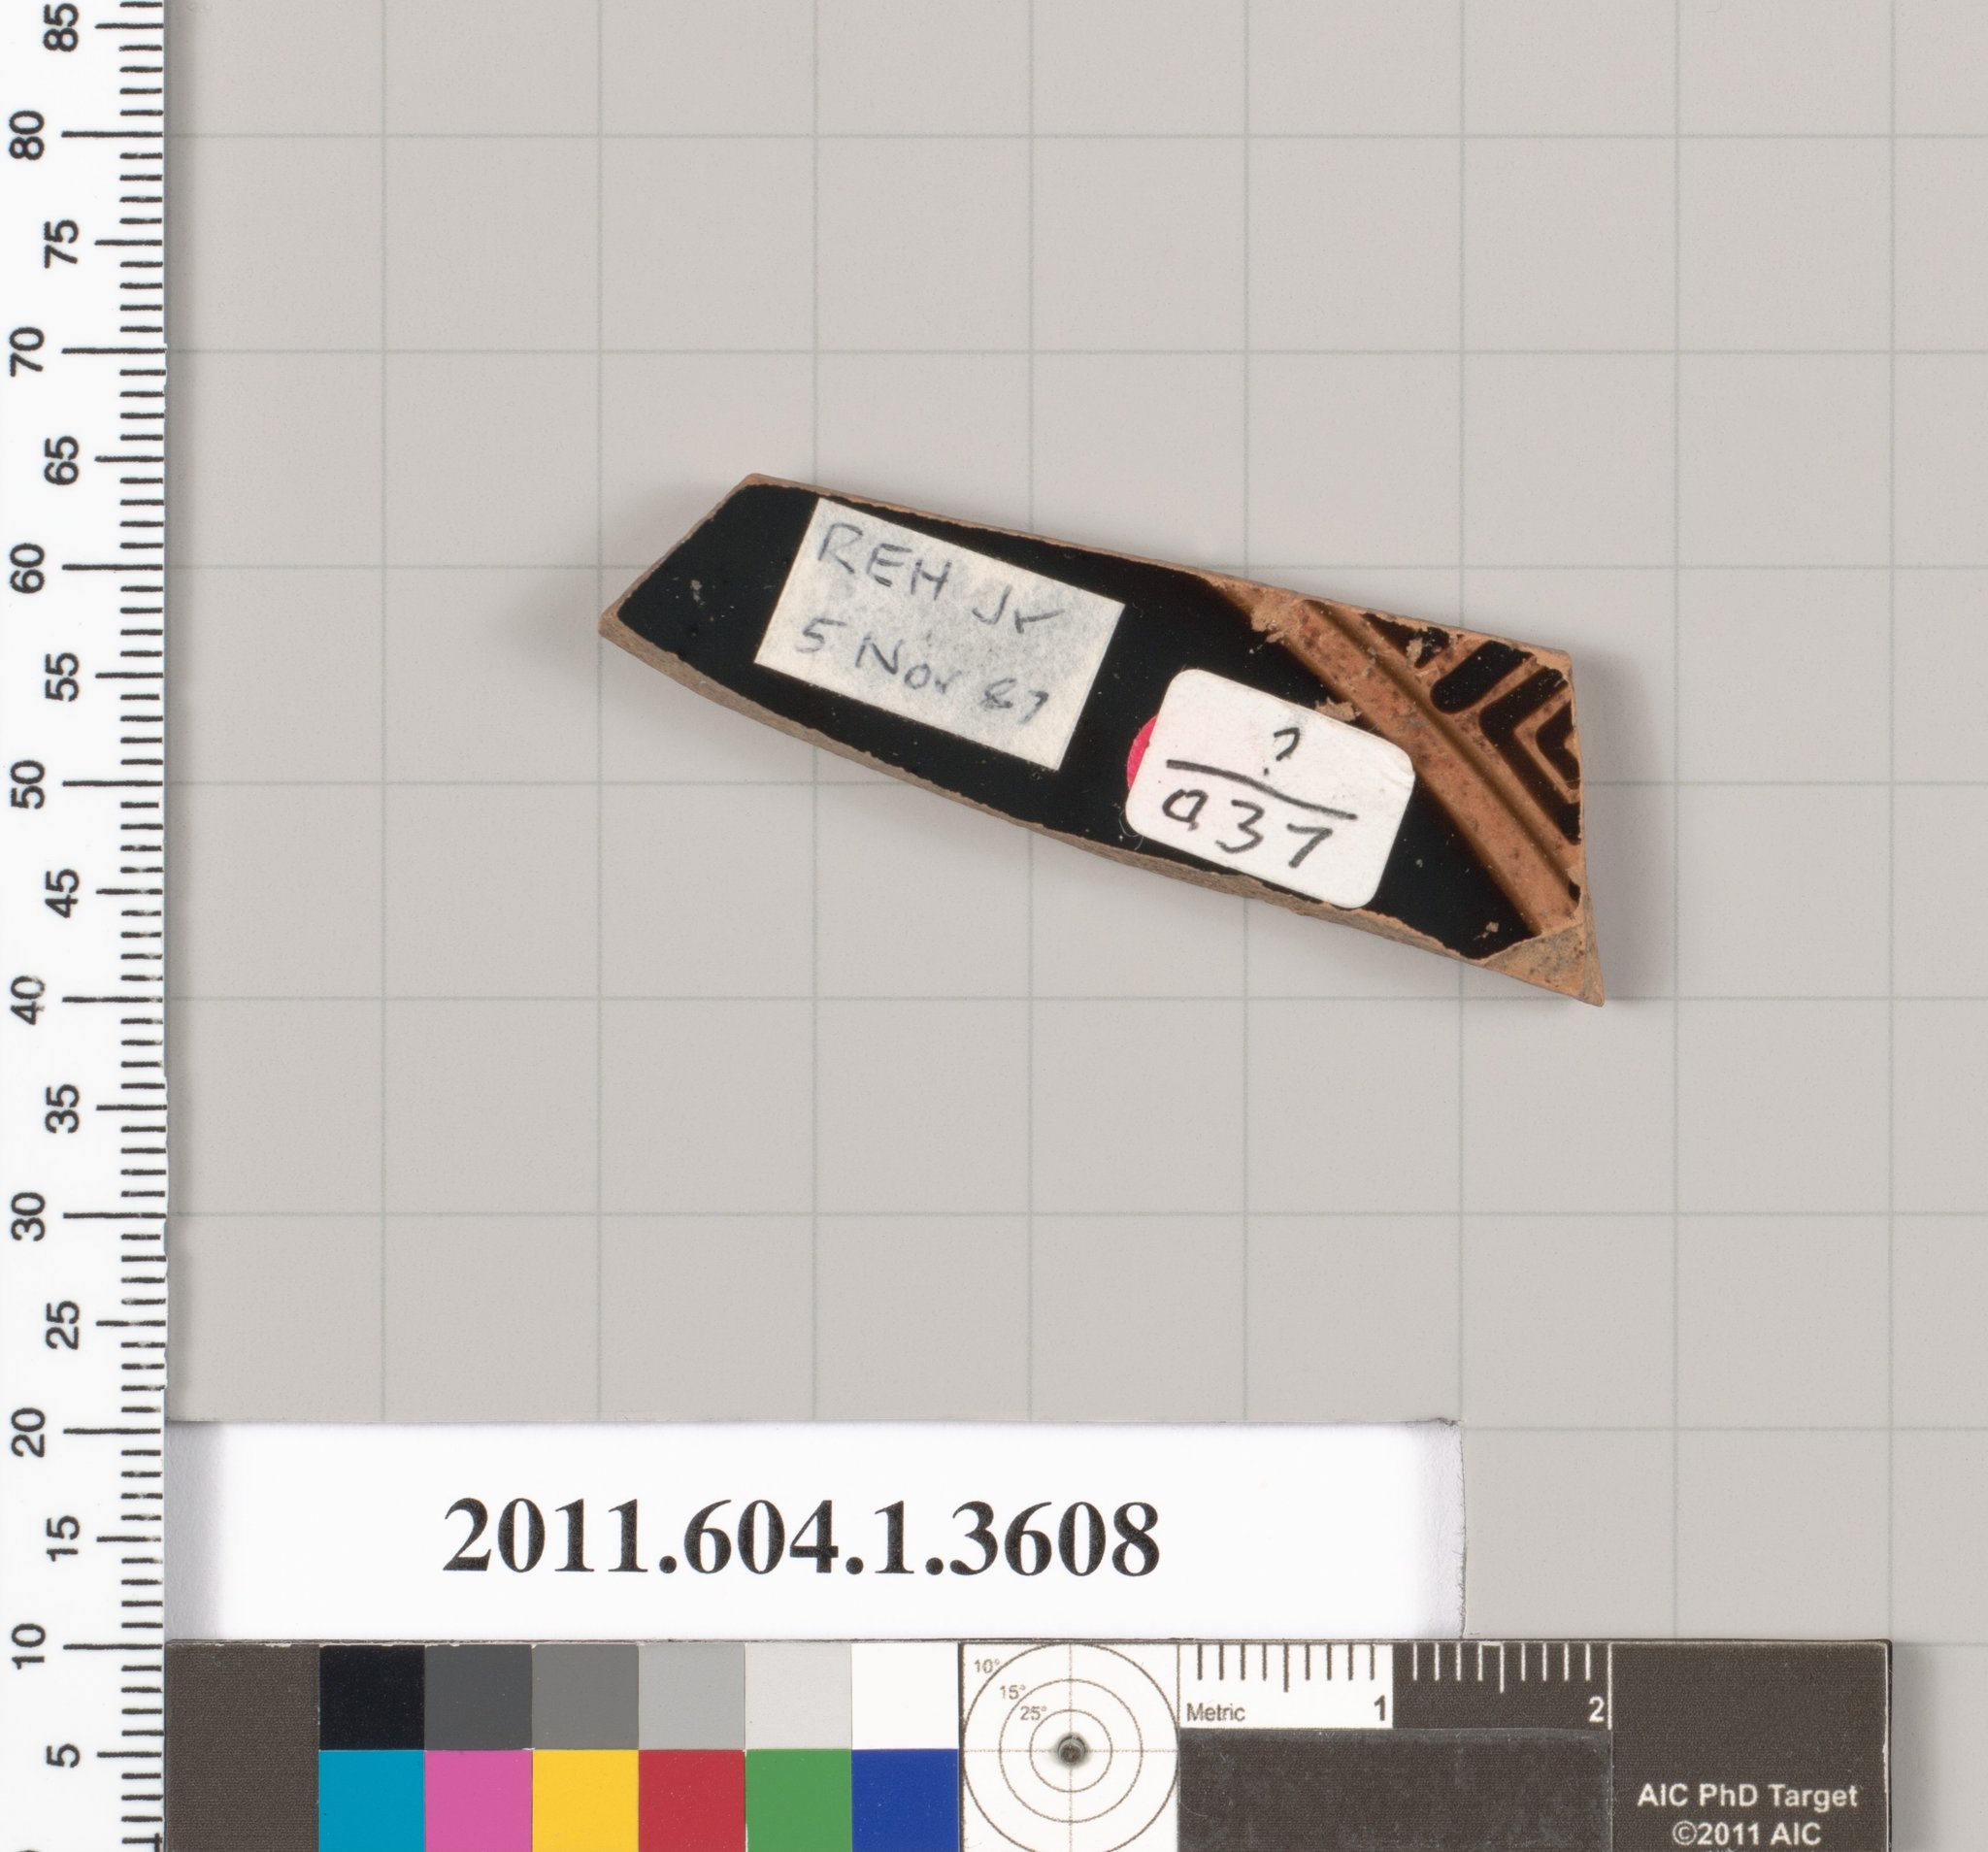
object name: kylix fragment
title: Terracotta fragment of a kylix (drinking cup)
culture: greek, attic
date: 500-480 BCE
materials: terracotta